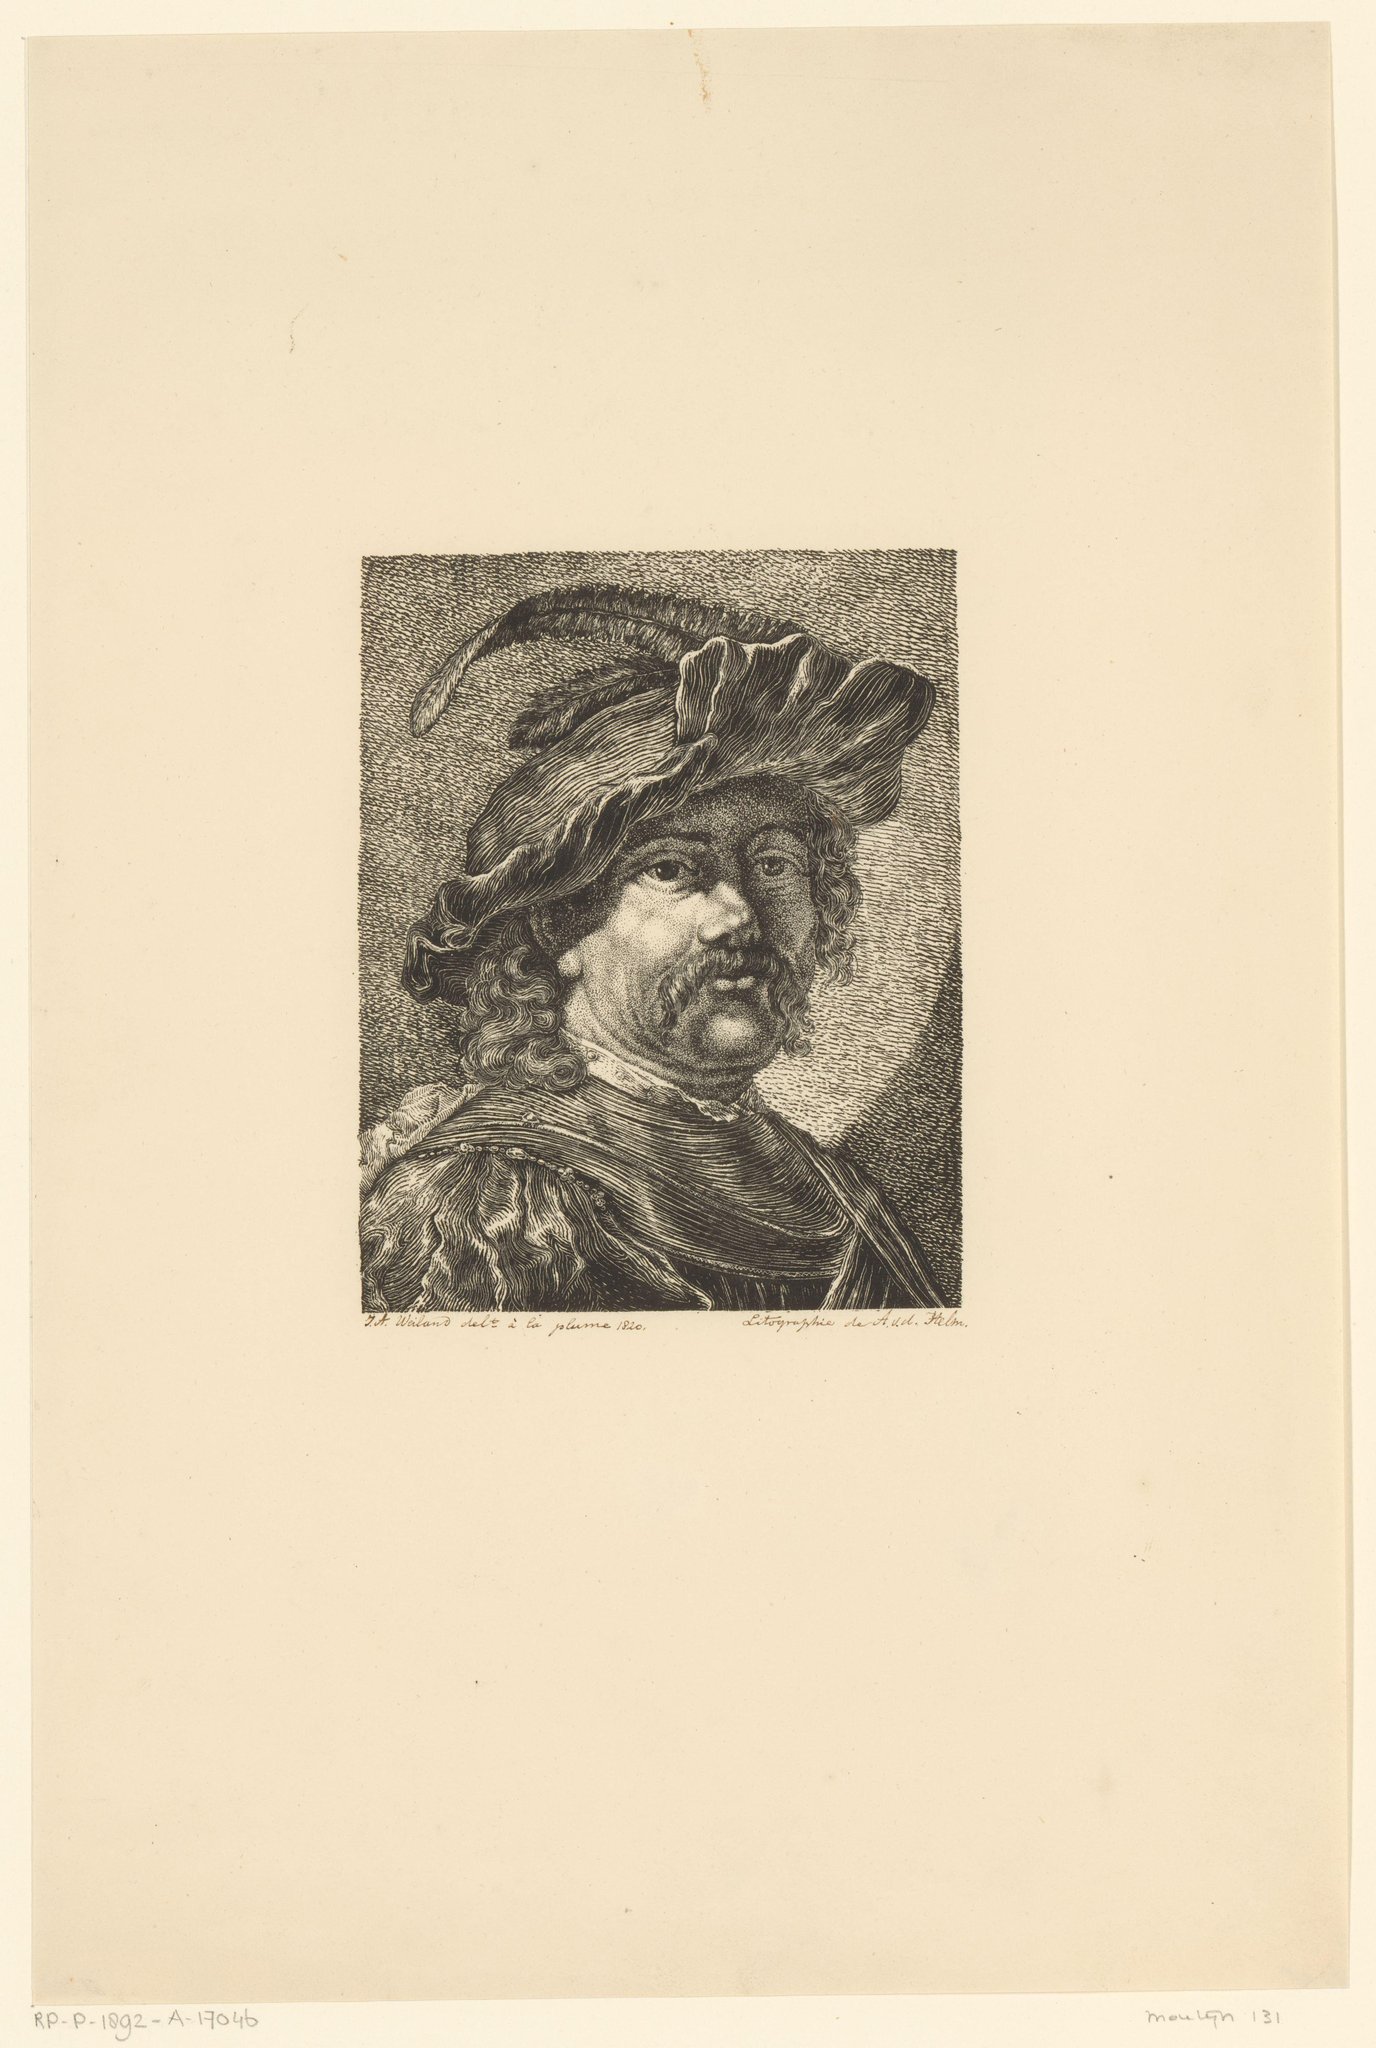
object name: print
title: Zelfportret van Rembrandt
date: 1820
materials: paper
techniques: lithograph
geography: rotterdam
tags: leiden, amsterdam, painter, print maker, draughtsman, rembrandt van rijn, historical persons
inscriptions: inscription: ‘J.A. Weiland delt. à la plume 1820 / Litographie de A. v.d. Helm’, collector's mark: Lugt 2228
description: Zelfportret van Rembrandt met gevederde baret.